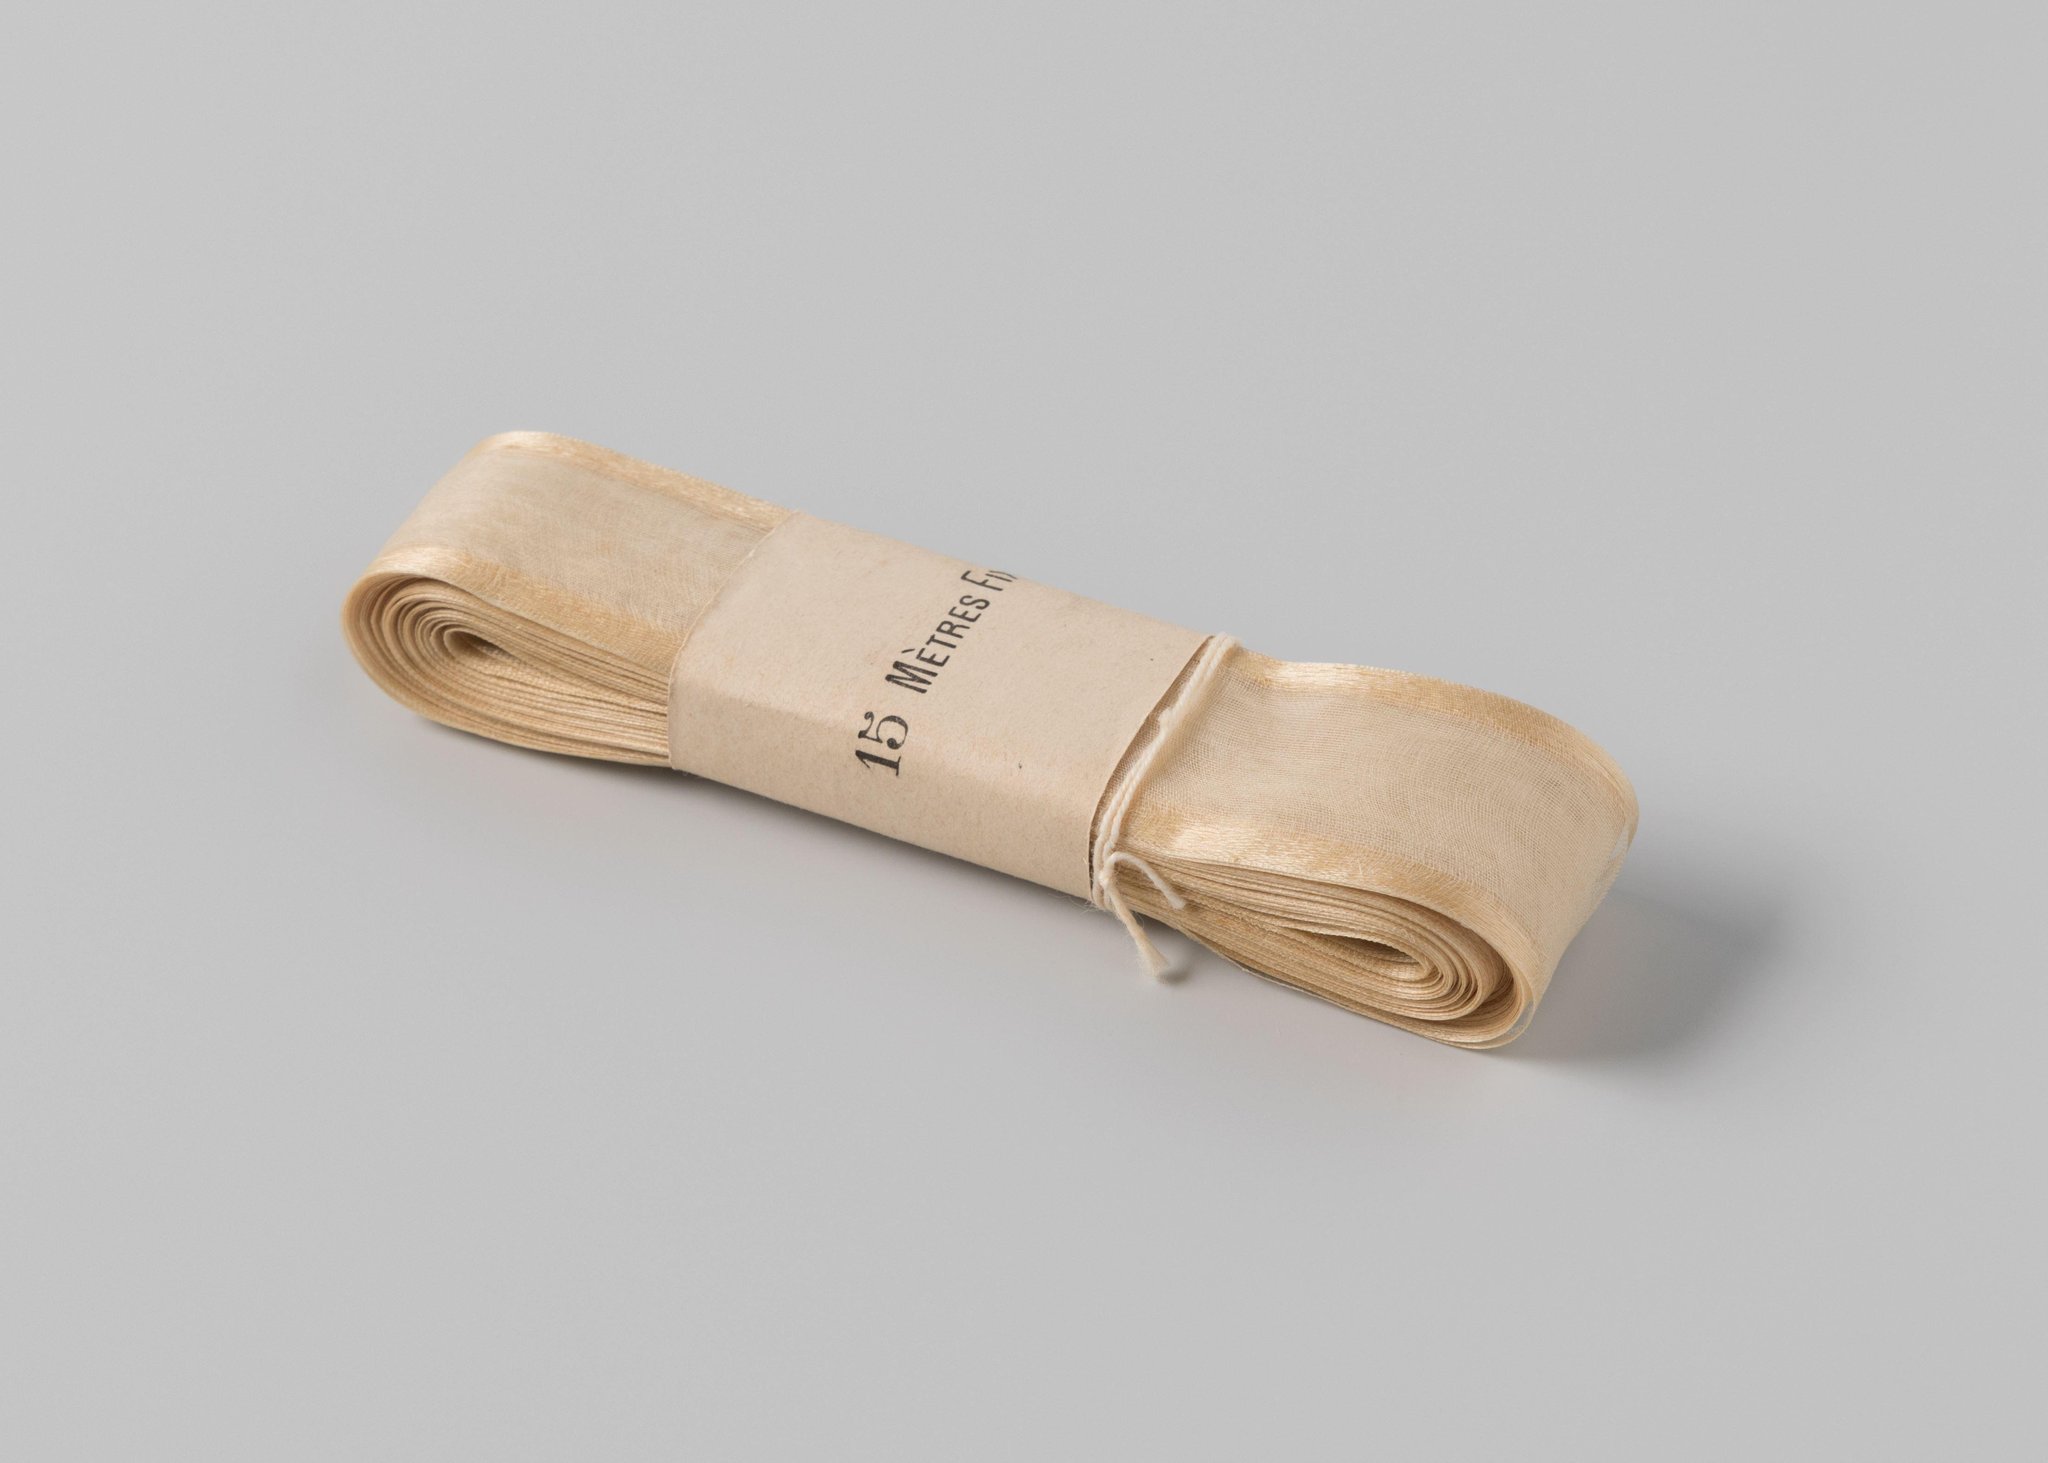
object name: ribbon material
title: Lint van crèmekleurig gaas van 15 meter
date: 1900-1915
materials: textile, silk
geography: nijmegen